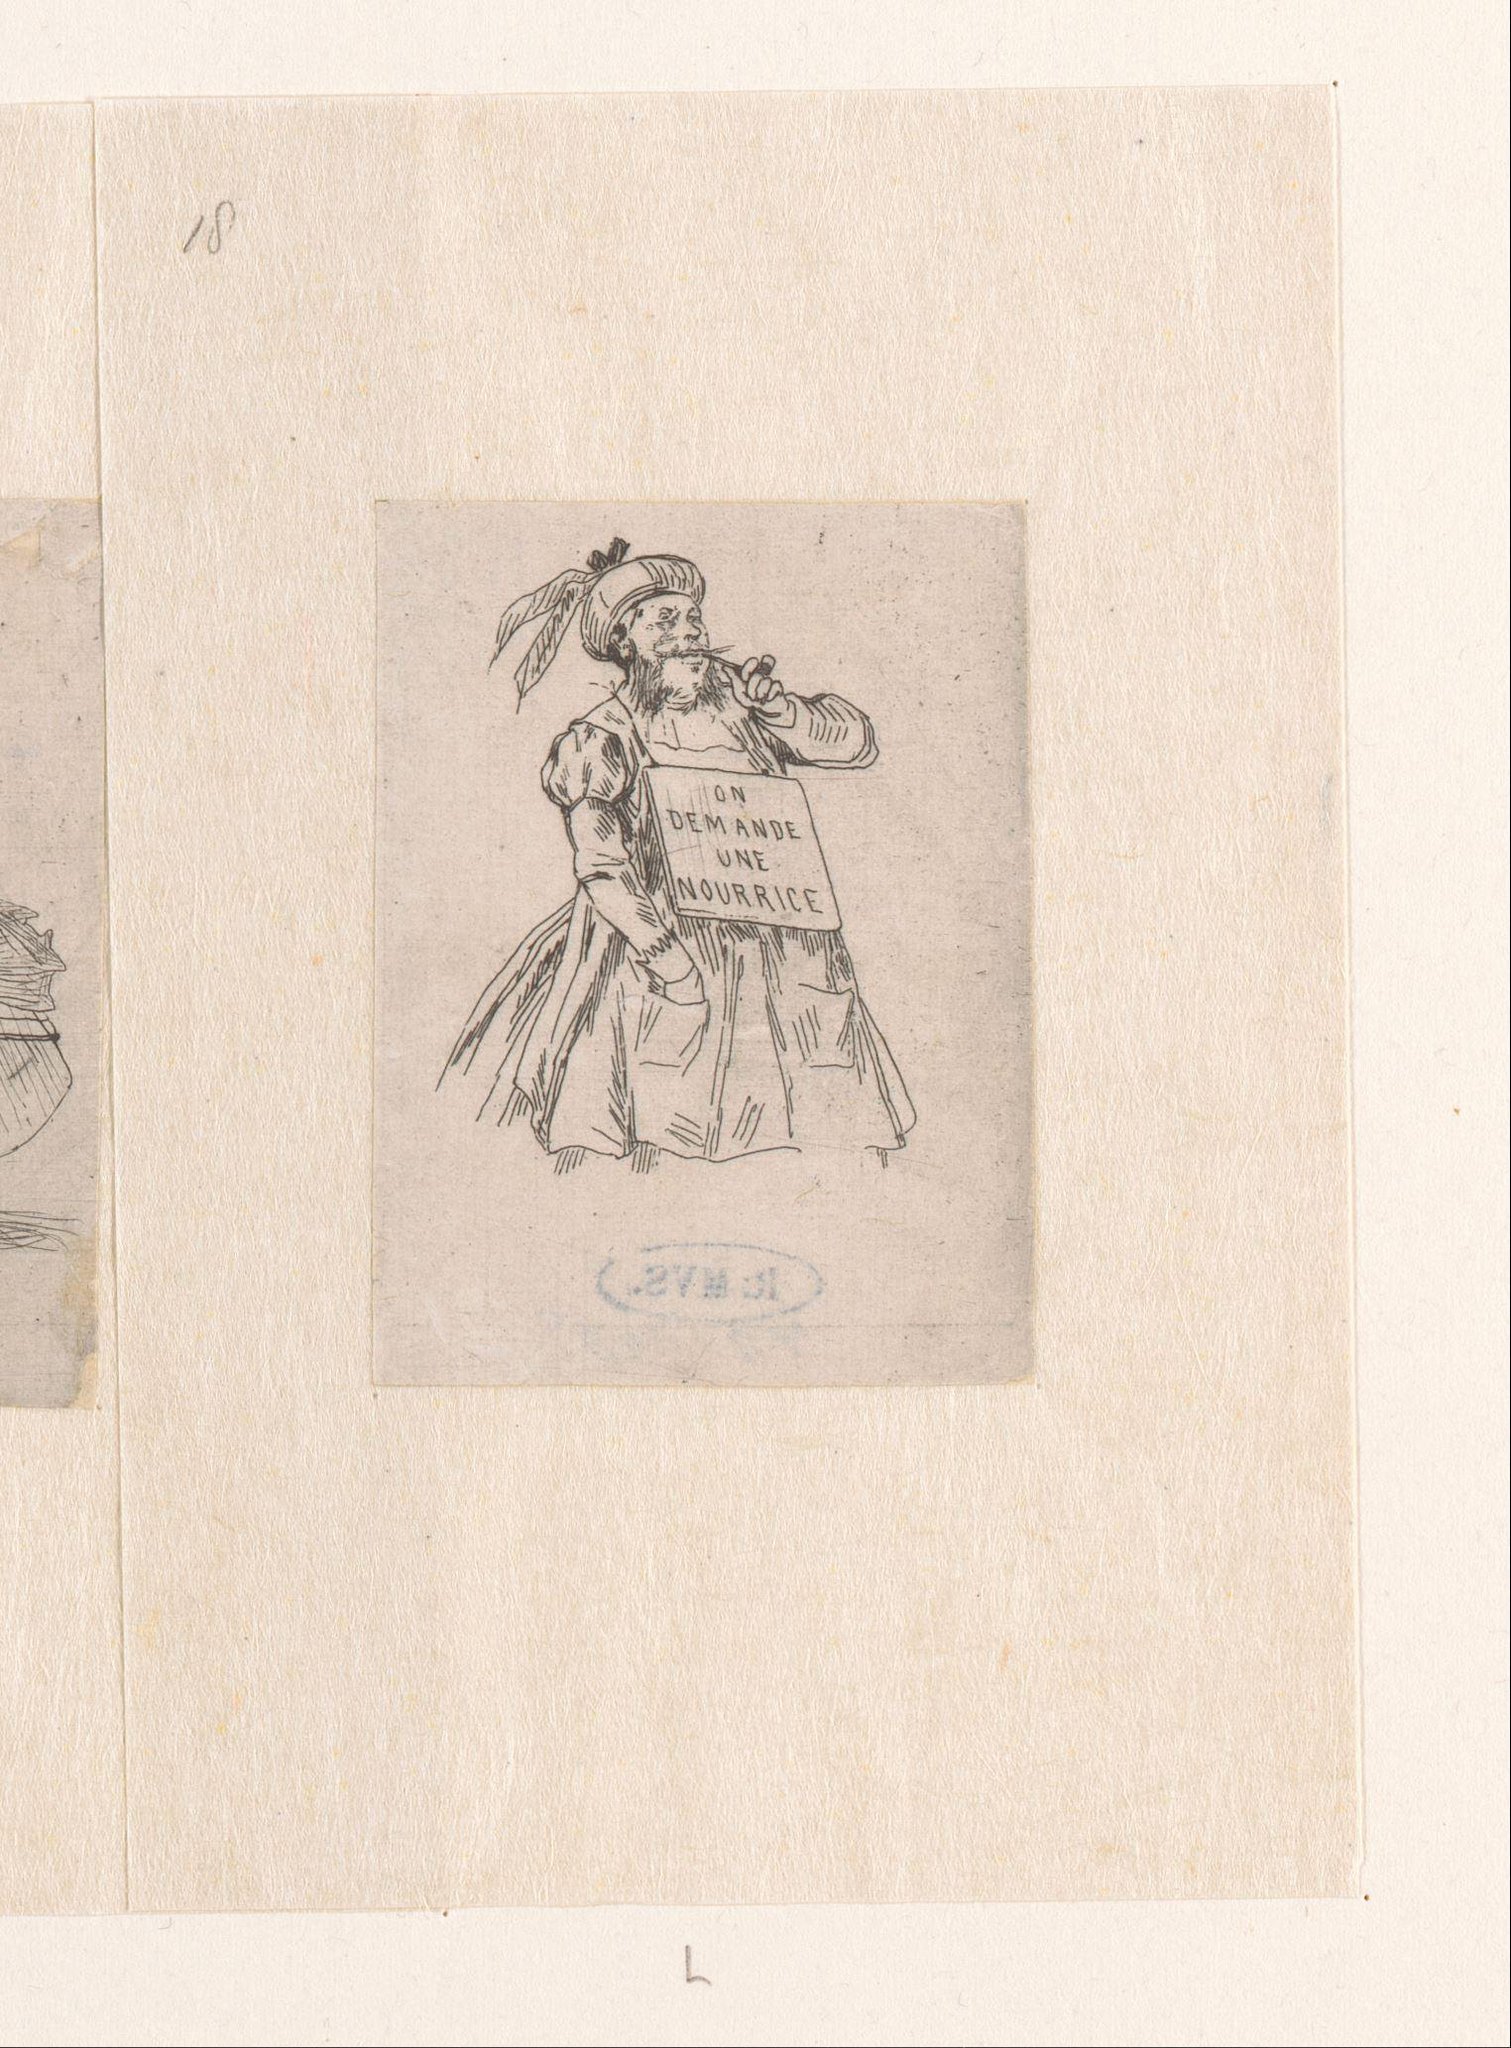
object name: print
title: Man met pijp en plakkaat om zijn nek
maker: félicien rops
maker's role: draughtsman, print maker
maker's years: 1833-1898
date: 1863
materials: paper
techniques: etching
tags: sandwich-man, adult man, pipe ~ tobacco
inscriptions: collector's mark: Lugt 2228